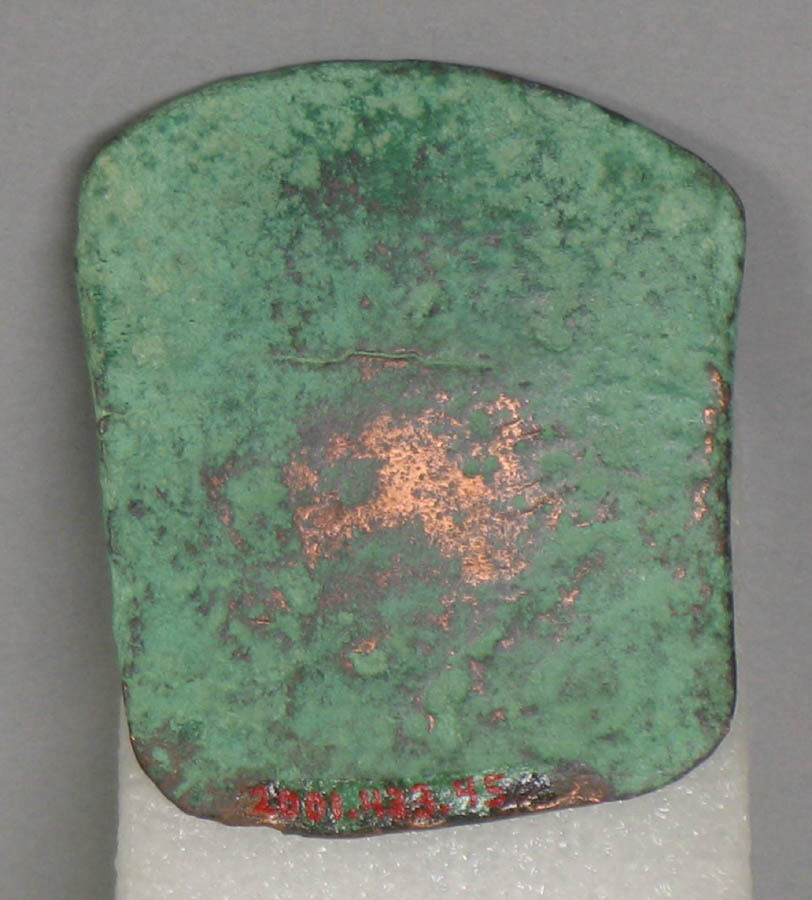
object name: ax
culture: indian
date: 1500-500 BCE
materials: copper